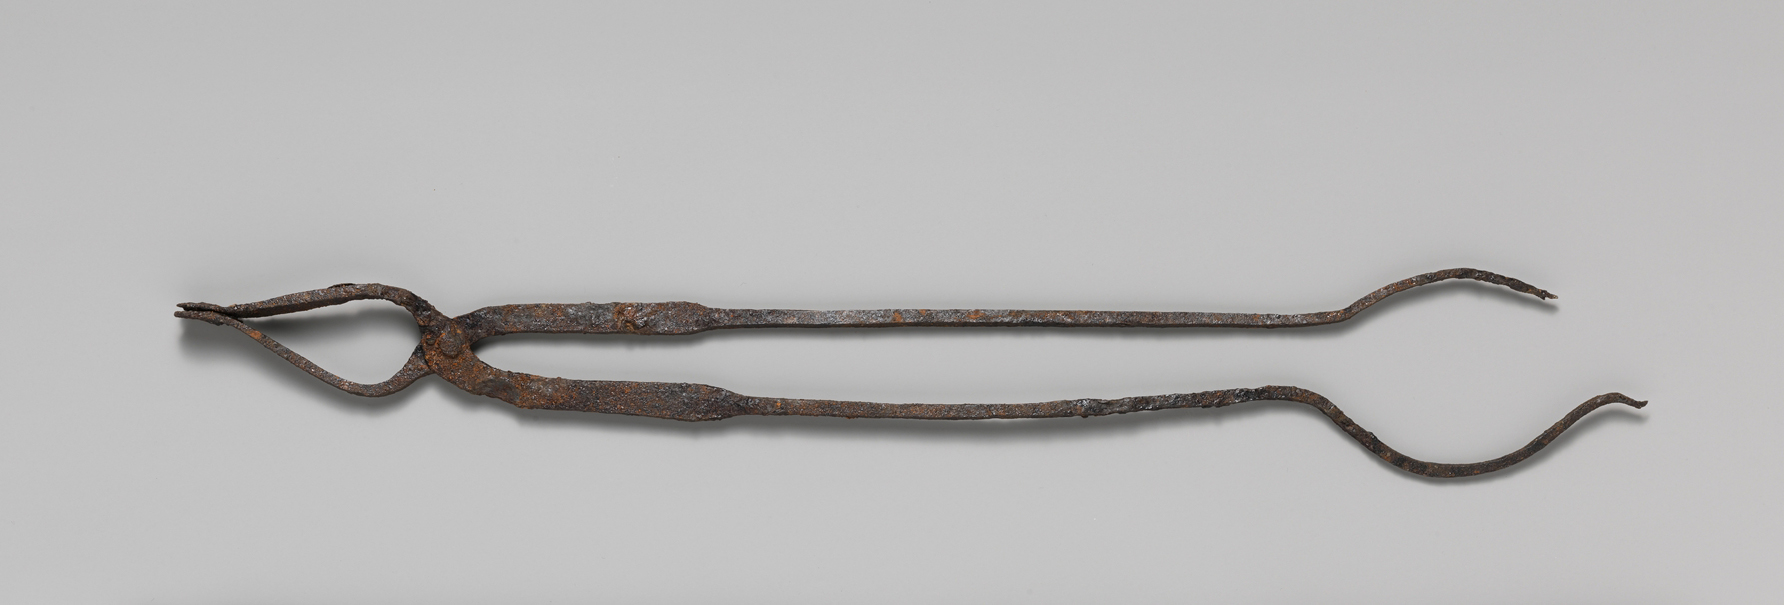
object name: fire tongs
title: Iron fire-tongs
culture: etruscan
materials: iron